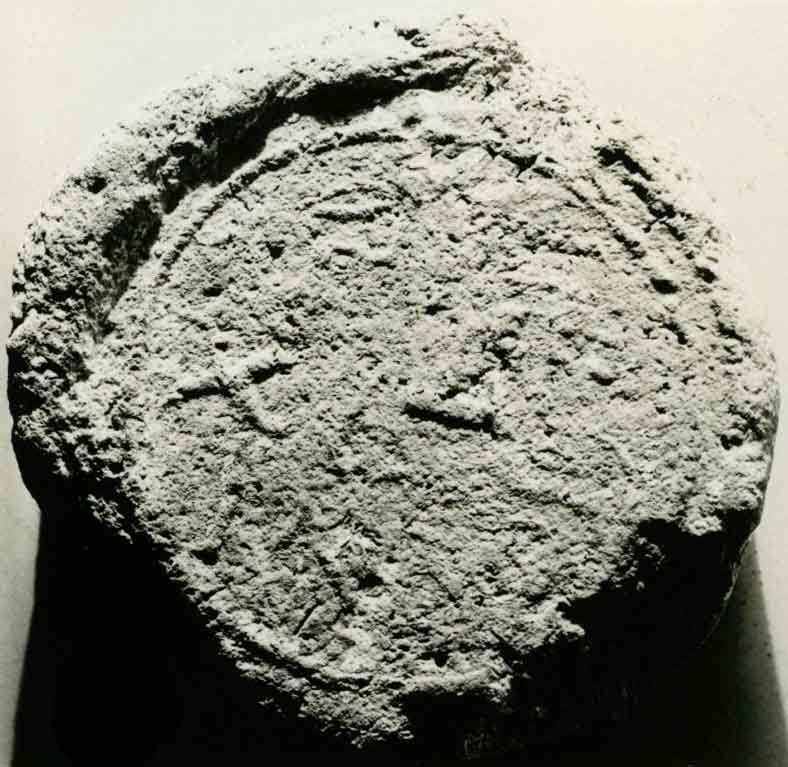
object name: cone, pahekmen, benia, circular impression, nursery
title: Funerary Cone of the Child of the Nursery Pahekmen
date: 1550-1295 BCE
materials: pottery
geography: egypt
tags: hieroglyphs